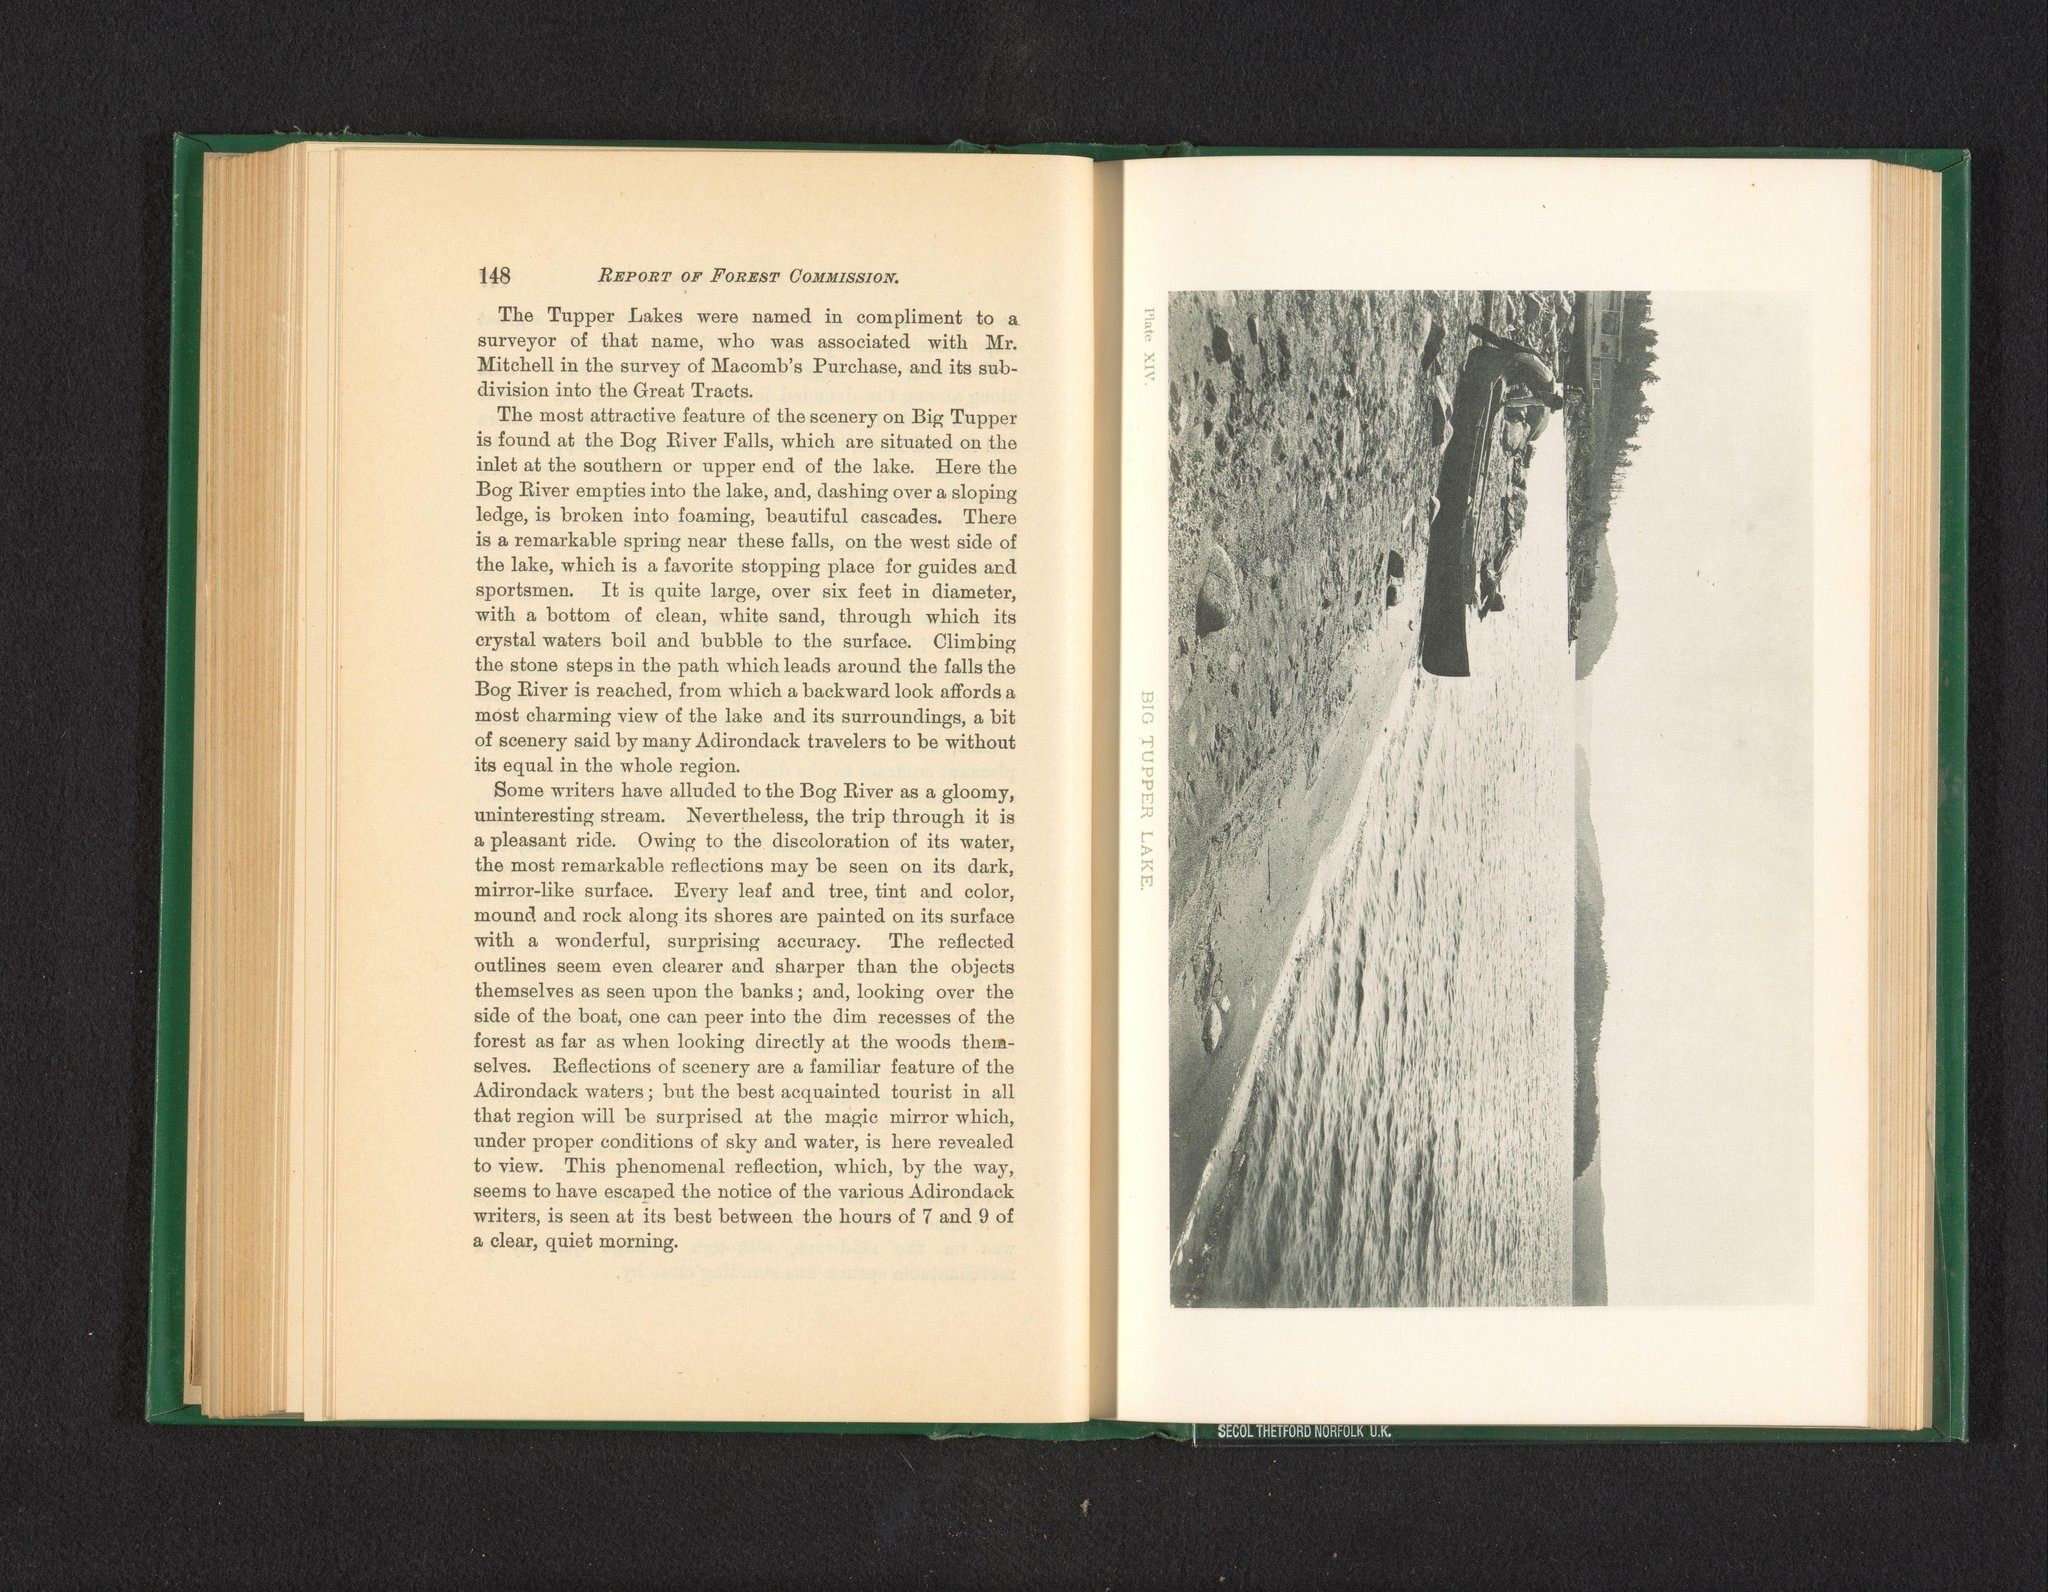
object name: page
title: Big Tupper Lake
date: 1891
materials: paper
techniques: photograph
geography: new york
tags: lake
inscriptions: number: ‘Plate XIV.’